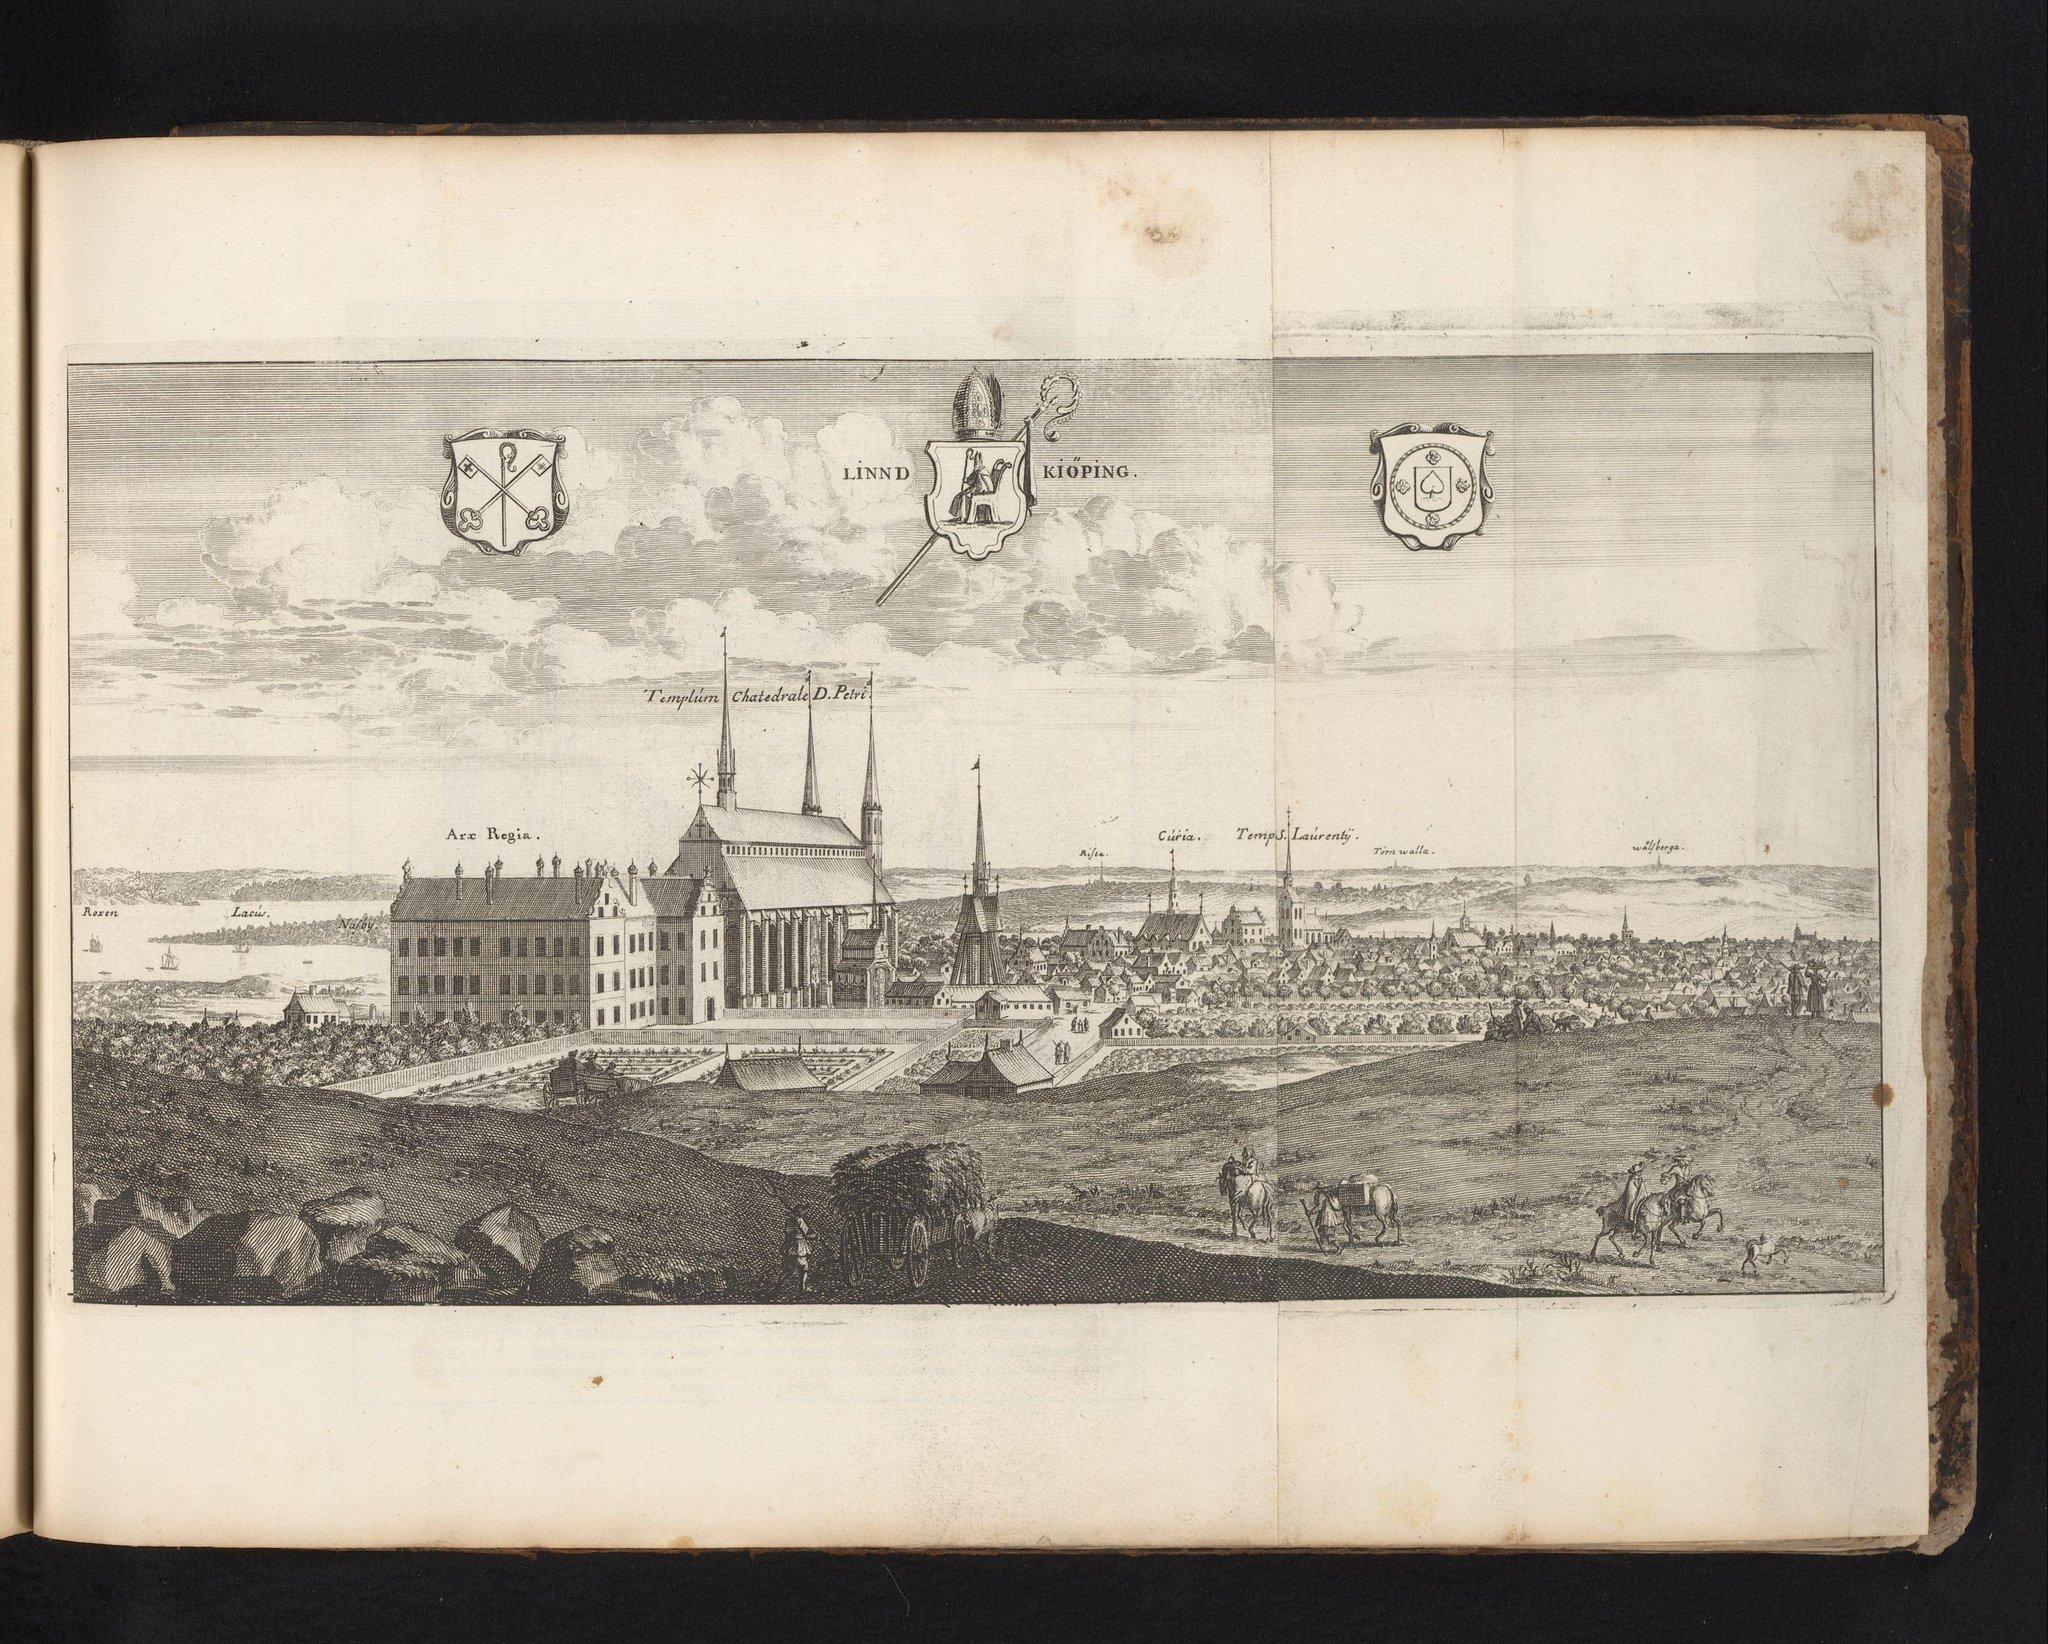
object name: album leaf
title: Suecia Antiqua et Hodierna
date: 1697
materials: paper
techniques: etching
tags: city-view in general; 'veduta'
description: Kungliga Biblioteket, 'Suecia': http://www.kb.se/samlingarna/Kartor-bilder/Suecia-antiqua/ (geraadpleegd november 2016).